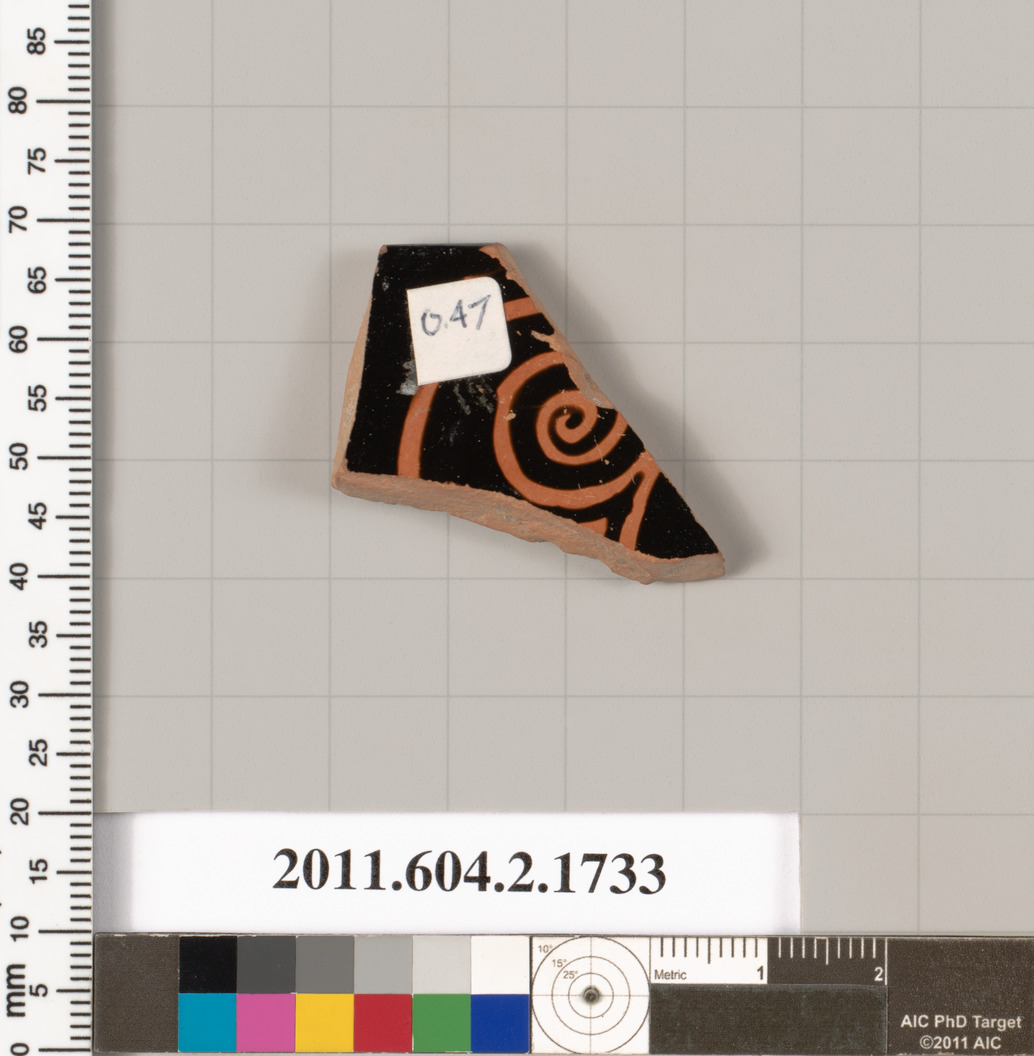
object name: skyphos fragment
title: Terracotta rim fragment of a skyphos (deep drinking cup)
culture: greek, attic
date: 475-451 BCE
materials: terracotta